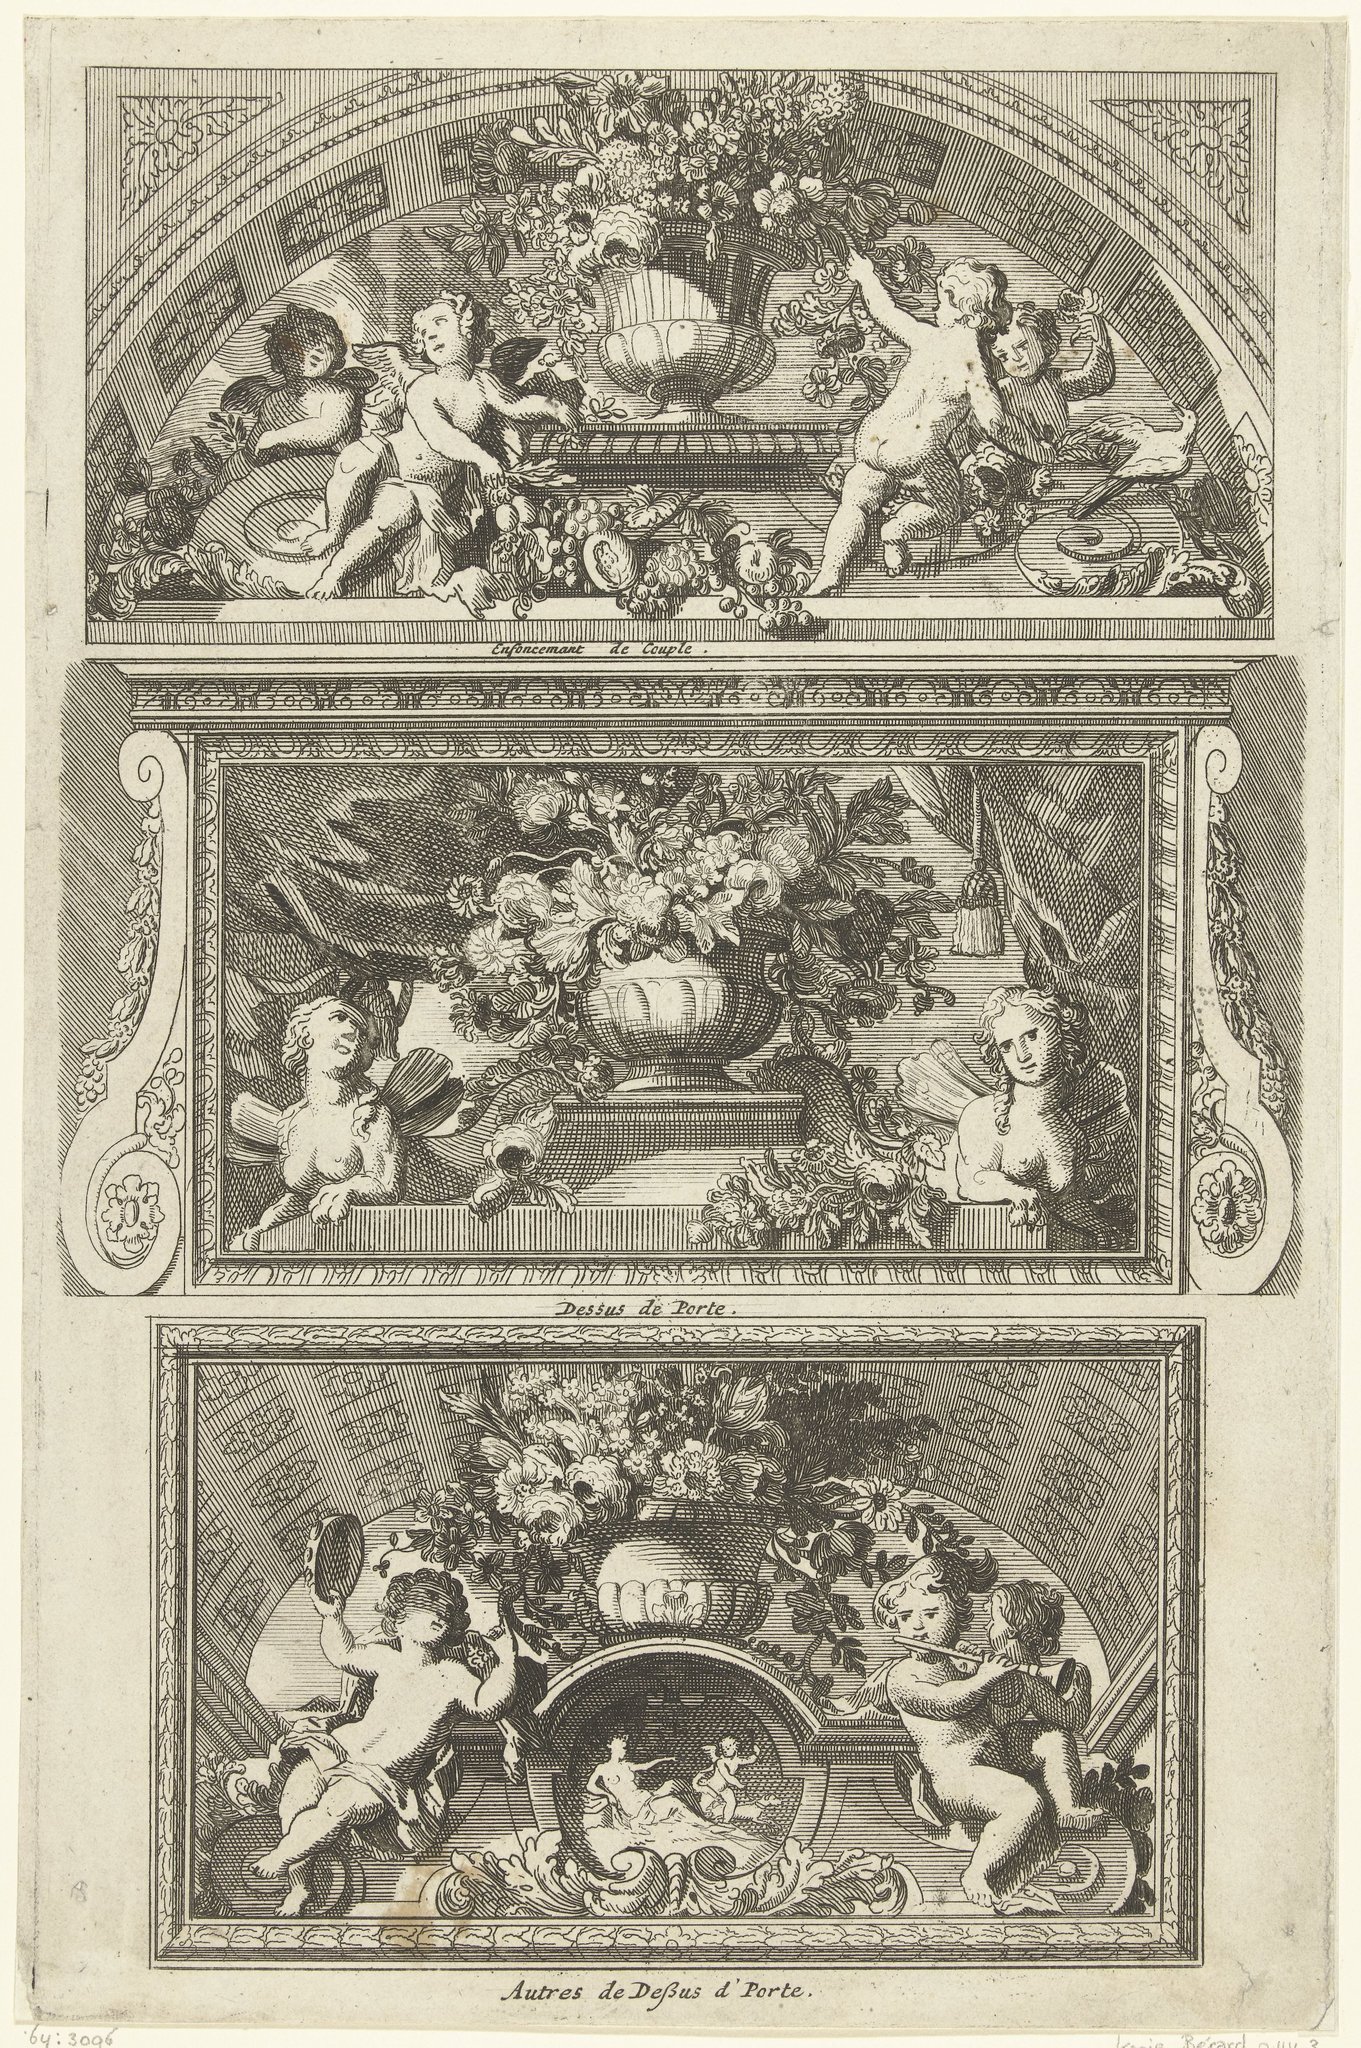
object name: ornament print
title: Gebogen nis en twee horizontale bovendeurspanelen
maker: daniël marot (i)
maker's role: draughtsman, print maker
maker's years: 1661-1752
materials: paper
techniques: etching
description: Een halfronde nis met bloemenvaas geflankeerd door putti. Daaronder een paneel met bloemenvaas geflankeerd door sfinxen en een paneel met een bloemenvaas geflankeerd door musicerende putti. Kopie naar blad uit de serie Nouveaux Liure de Tableaux de Portes uitgegeven door Daniel Marot tussen 1703 en 1712.